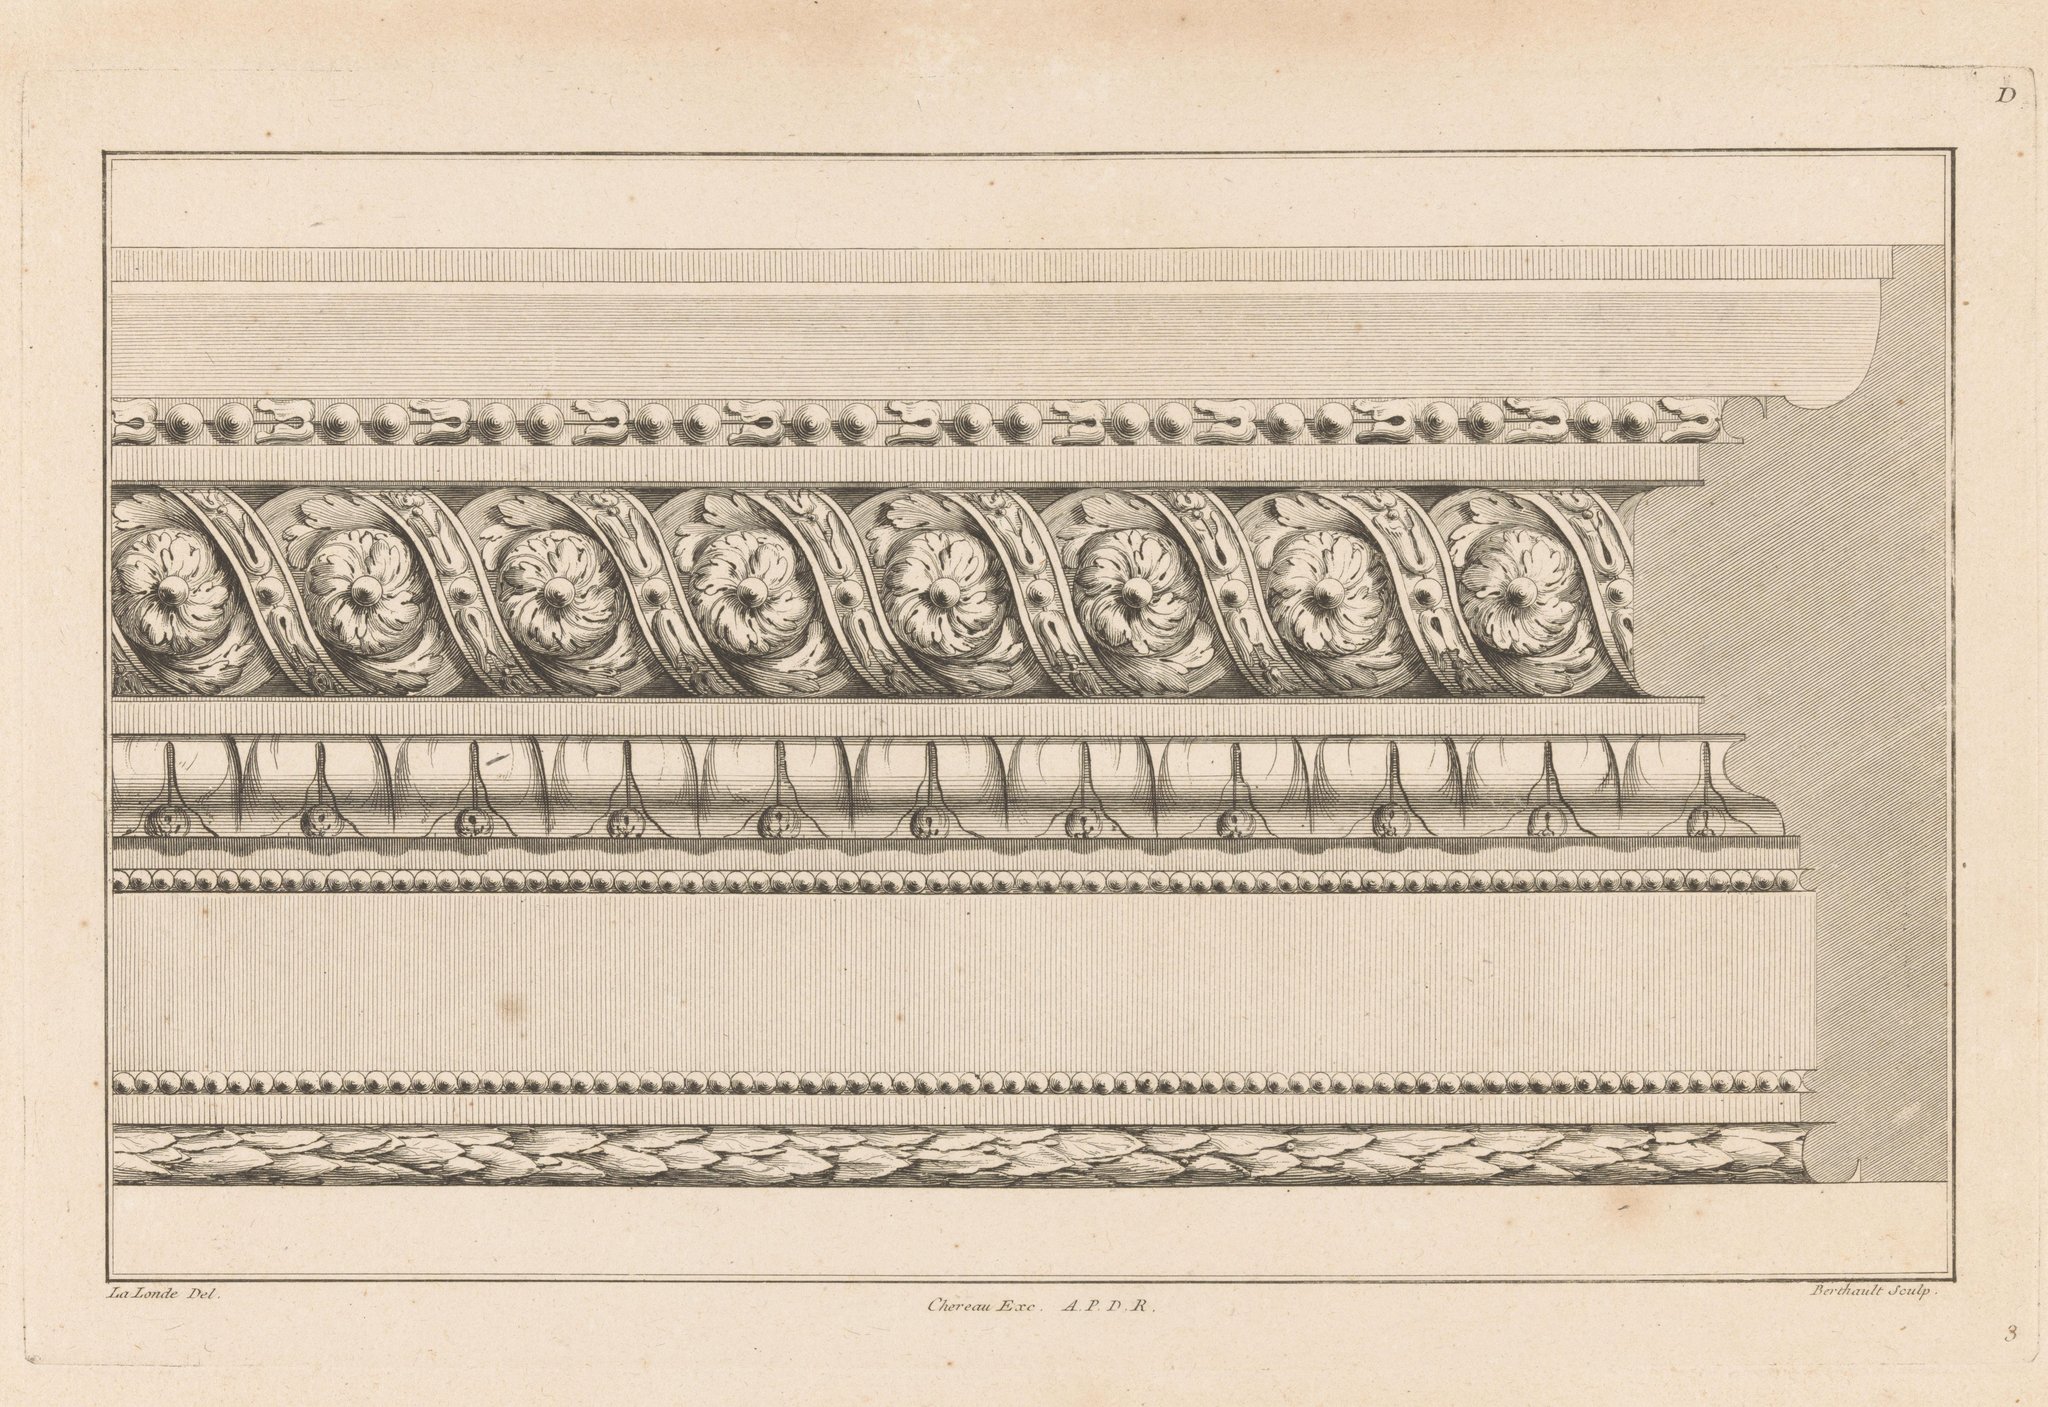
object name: print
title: D IIIe Cahier de Bordures à l'usage de la Sculpture &c, avec leurs Profils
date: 1784-1785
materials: paper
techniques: engraving, etching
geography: paris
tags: ornaments ~ art (+ framing decorations)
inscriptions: collector's mark: Lugt 2228, collector's mark: Lugt 2760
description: Een geornamenteerde lijst met bloemmotieven en tulpen.